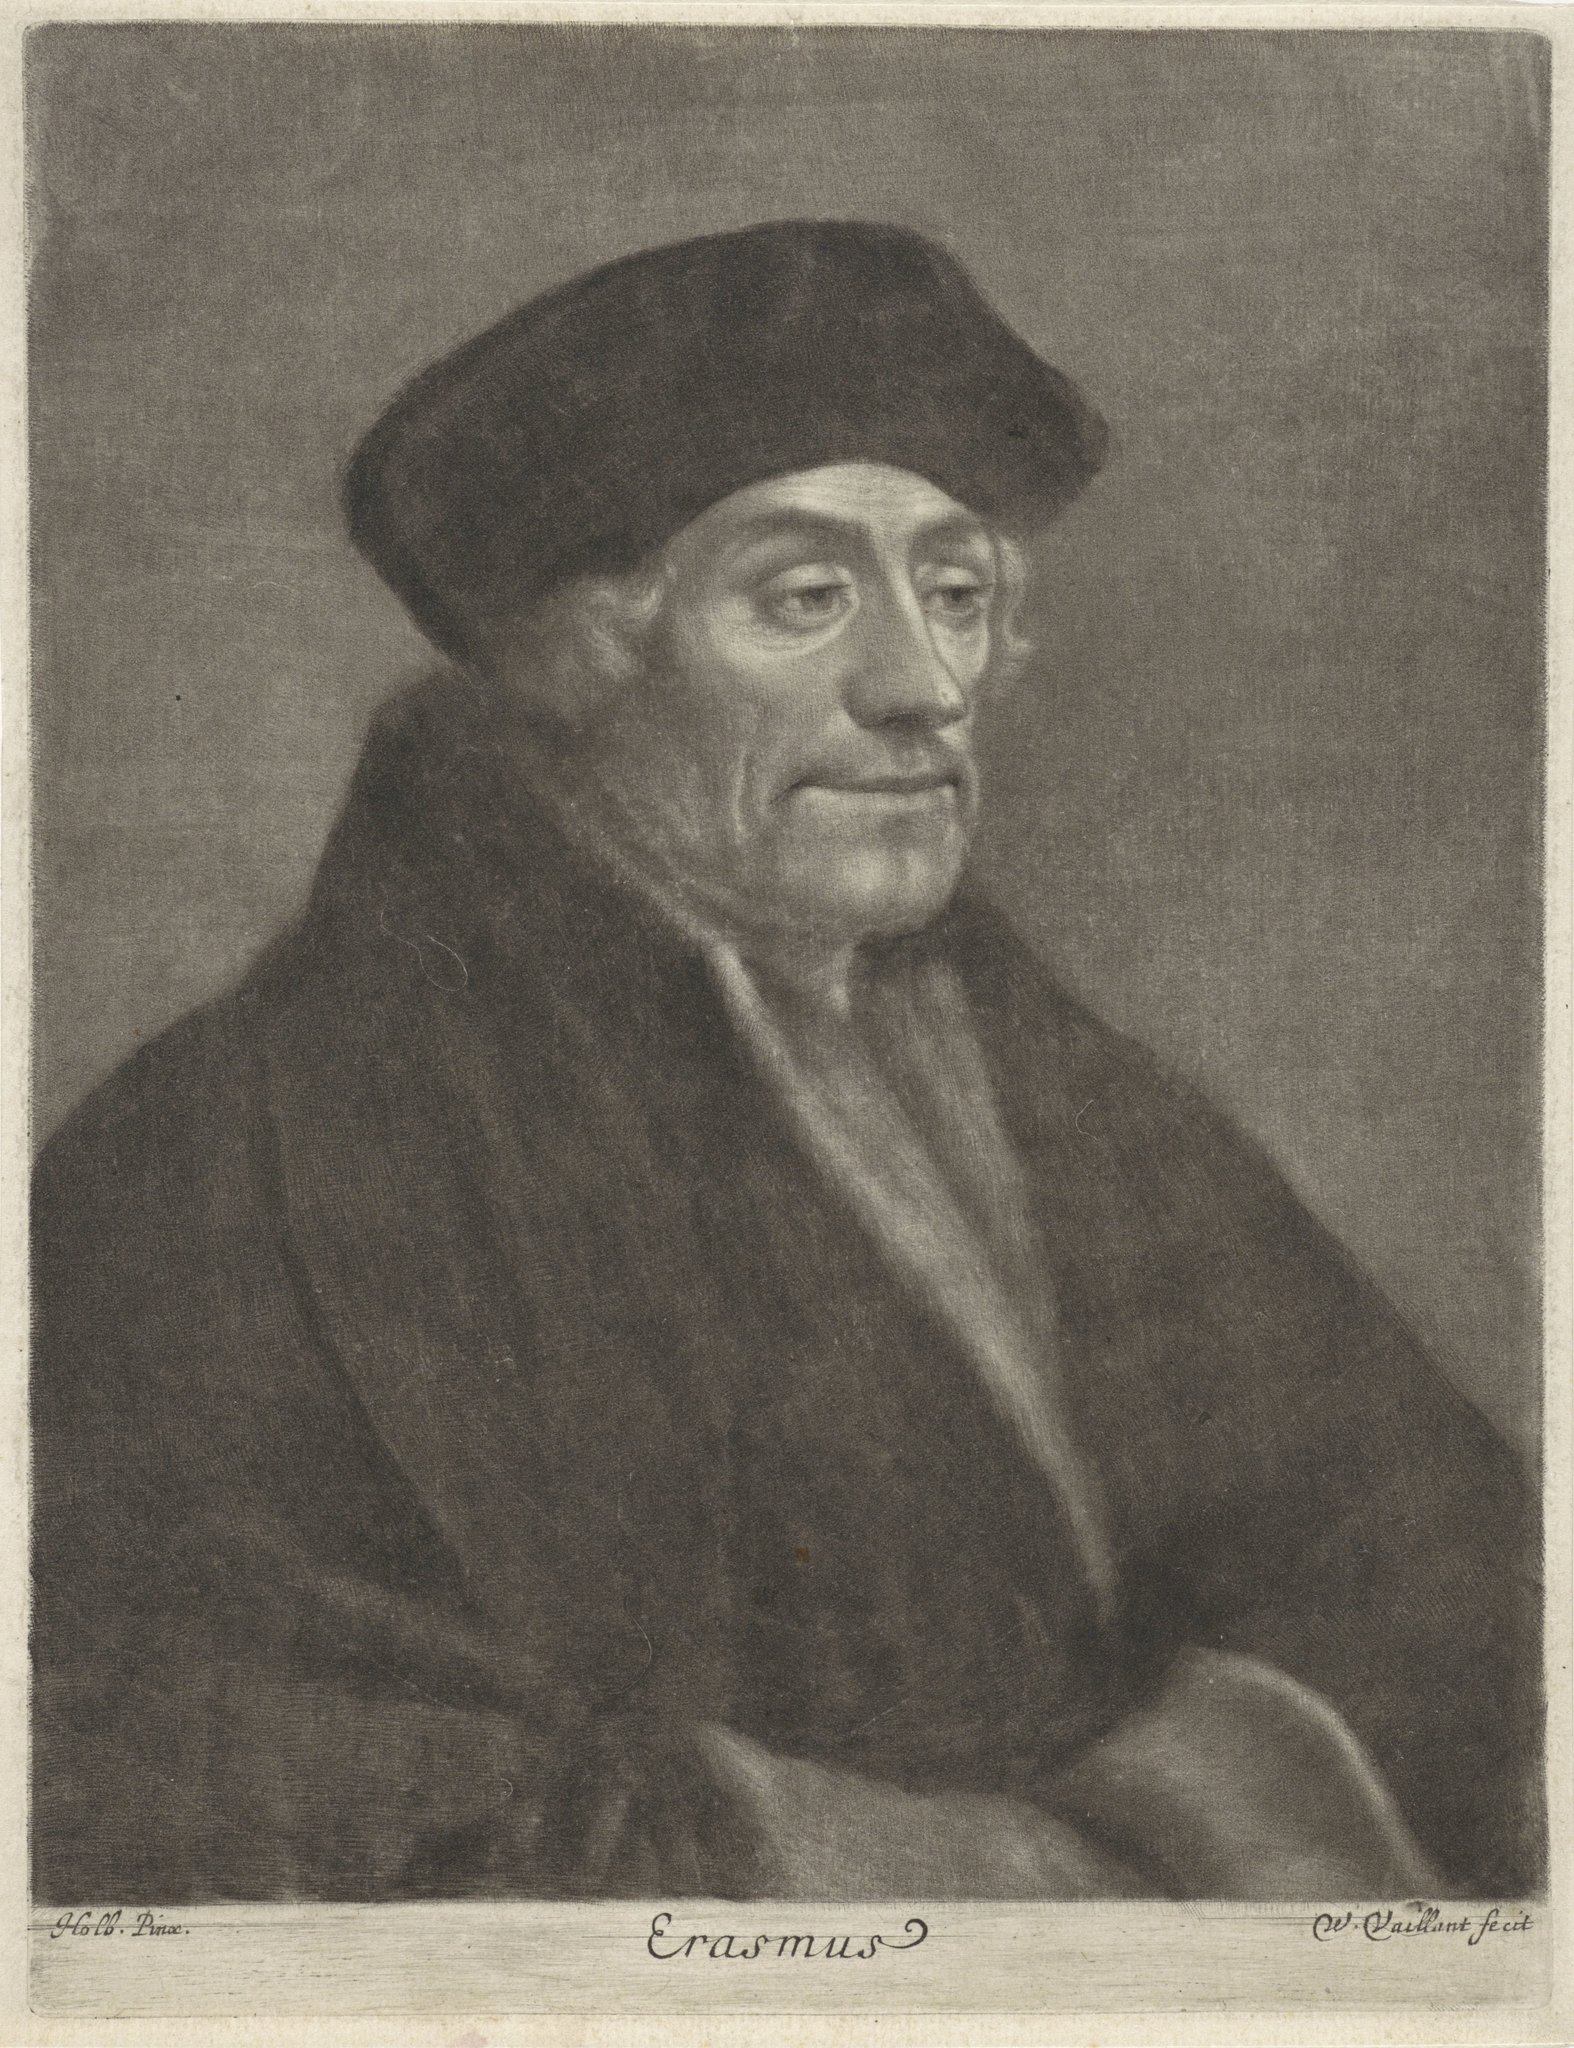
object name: print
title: Portret van Desiderius Erasmus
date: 1658-1677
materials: paper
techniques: mezzotint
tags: rotterdam, desiderius erasmus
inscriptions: collector's mark: Lugt 2228